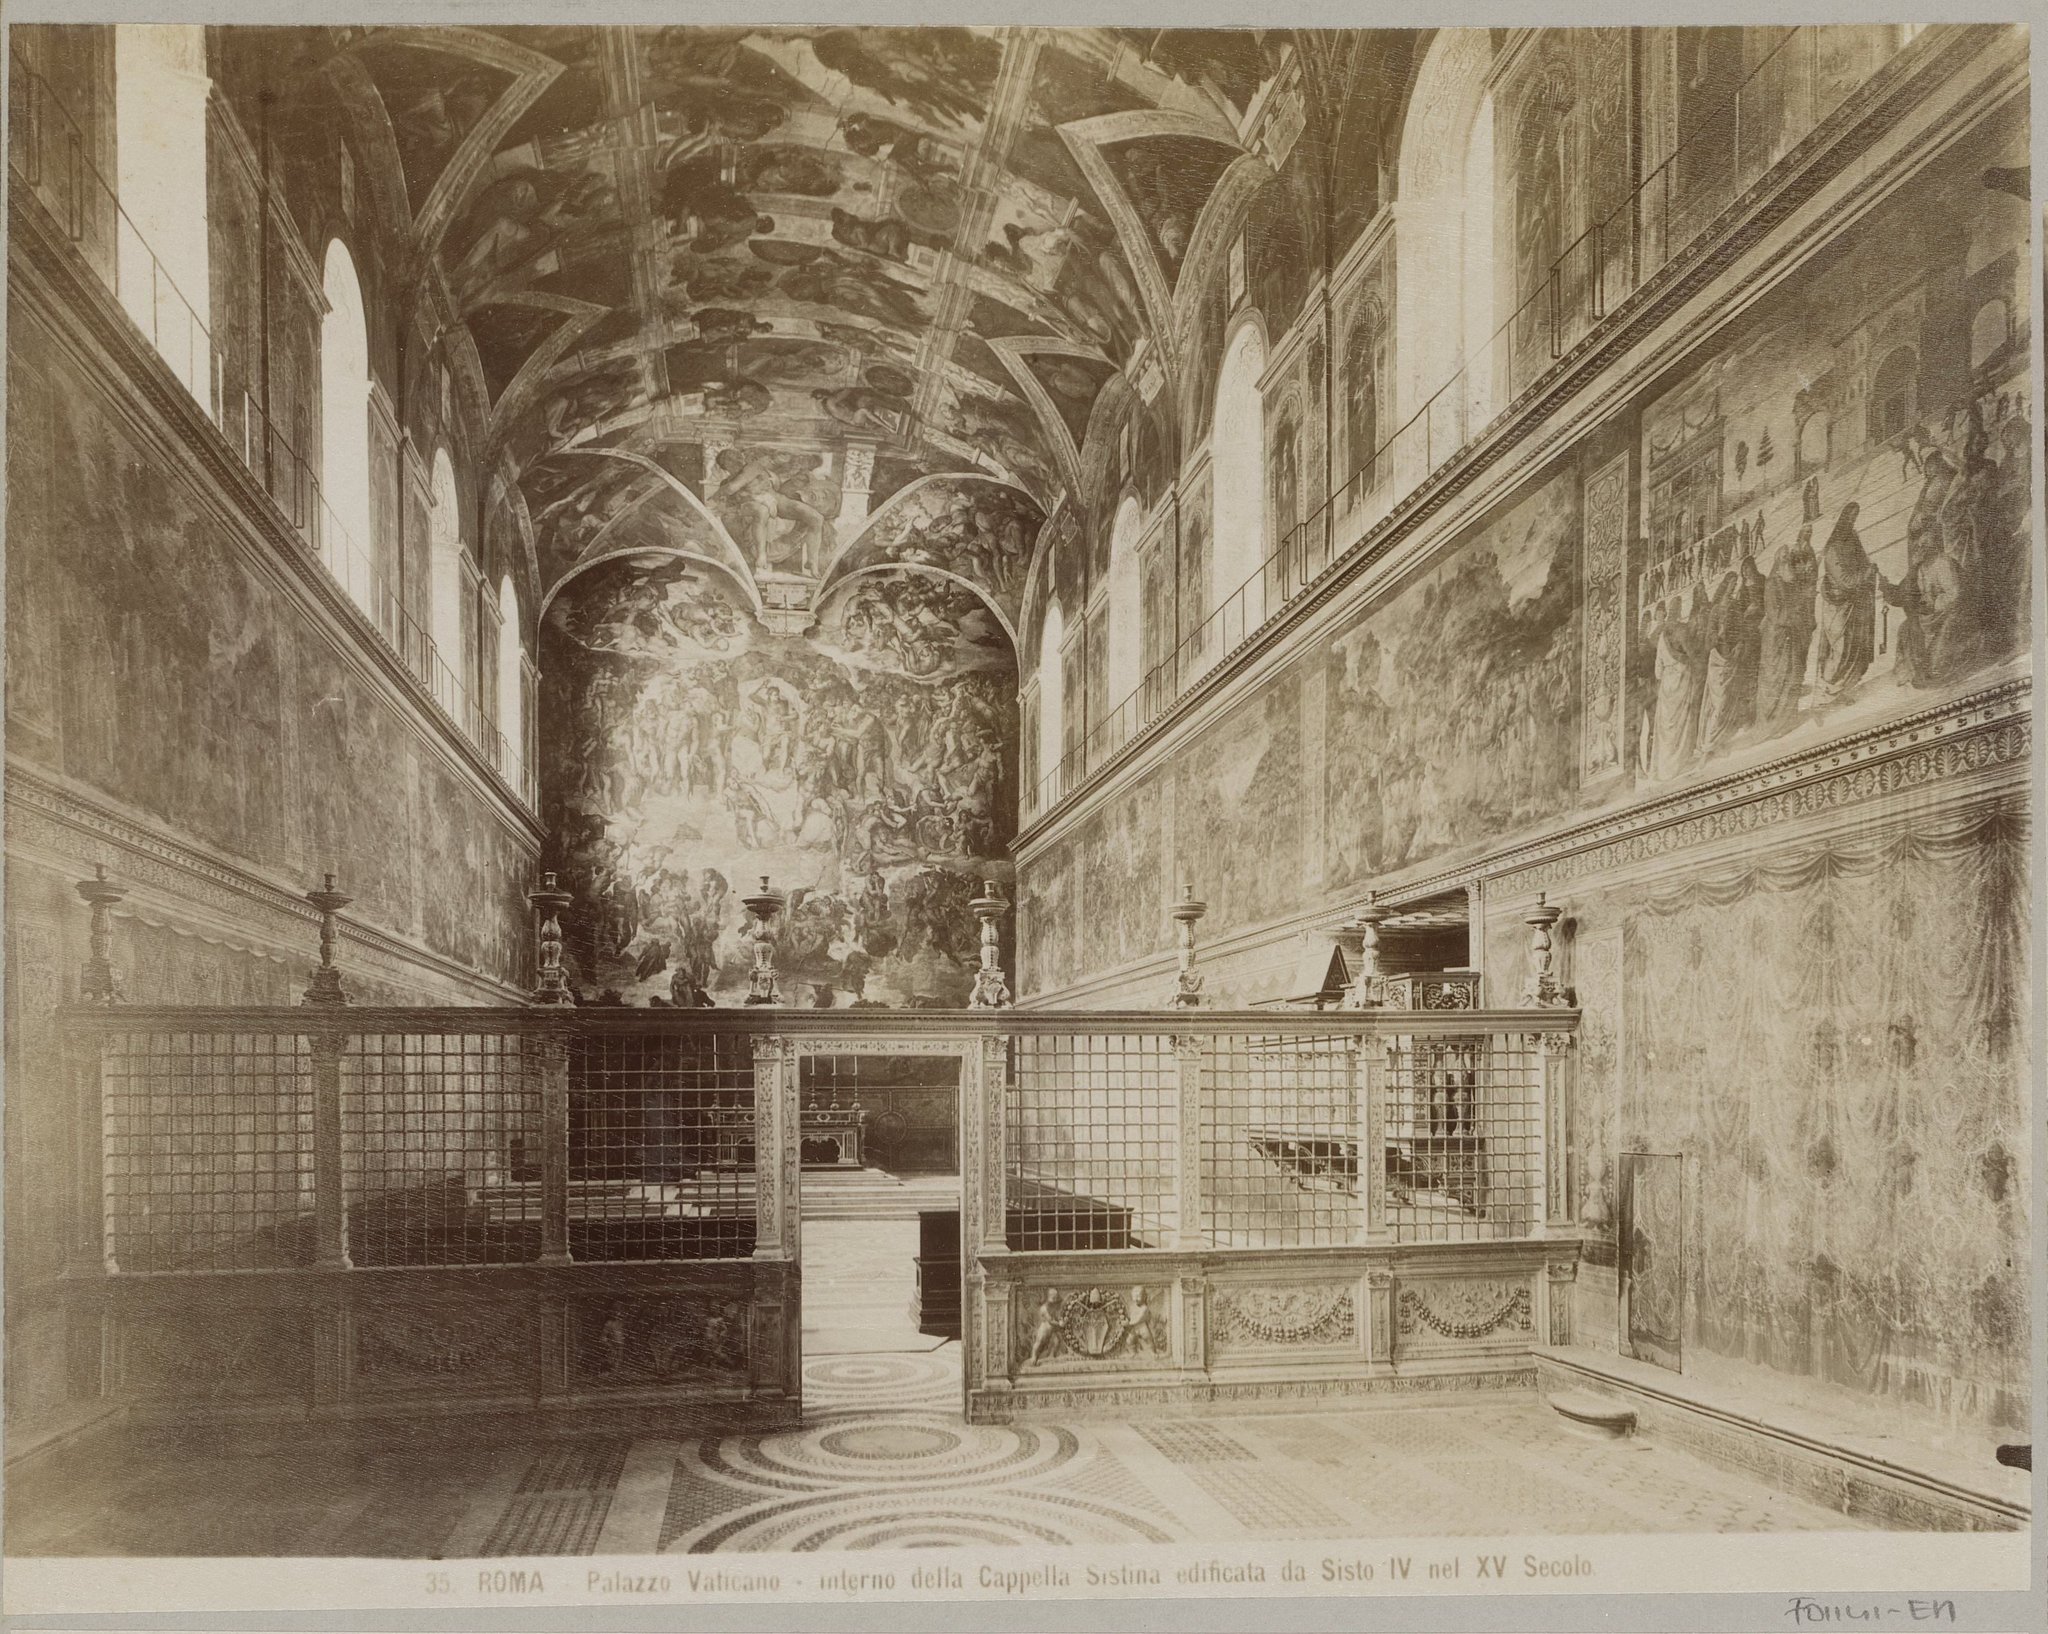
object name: photograph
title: Interieur van de Sixtijnse Kapel in Vaticaanstad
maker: Anonymous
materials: photographic support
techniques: albumen print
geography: vatican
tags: painting (including book-illumination, miniature-painting) (+ plaster ~ arts), interior of church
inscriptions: number: ‘35’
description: Onderdeel van Fotoalbum van een reis door Zuid-Europa en het Midden-Oosten.